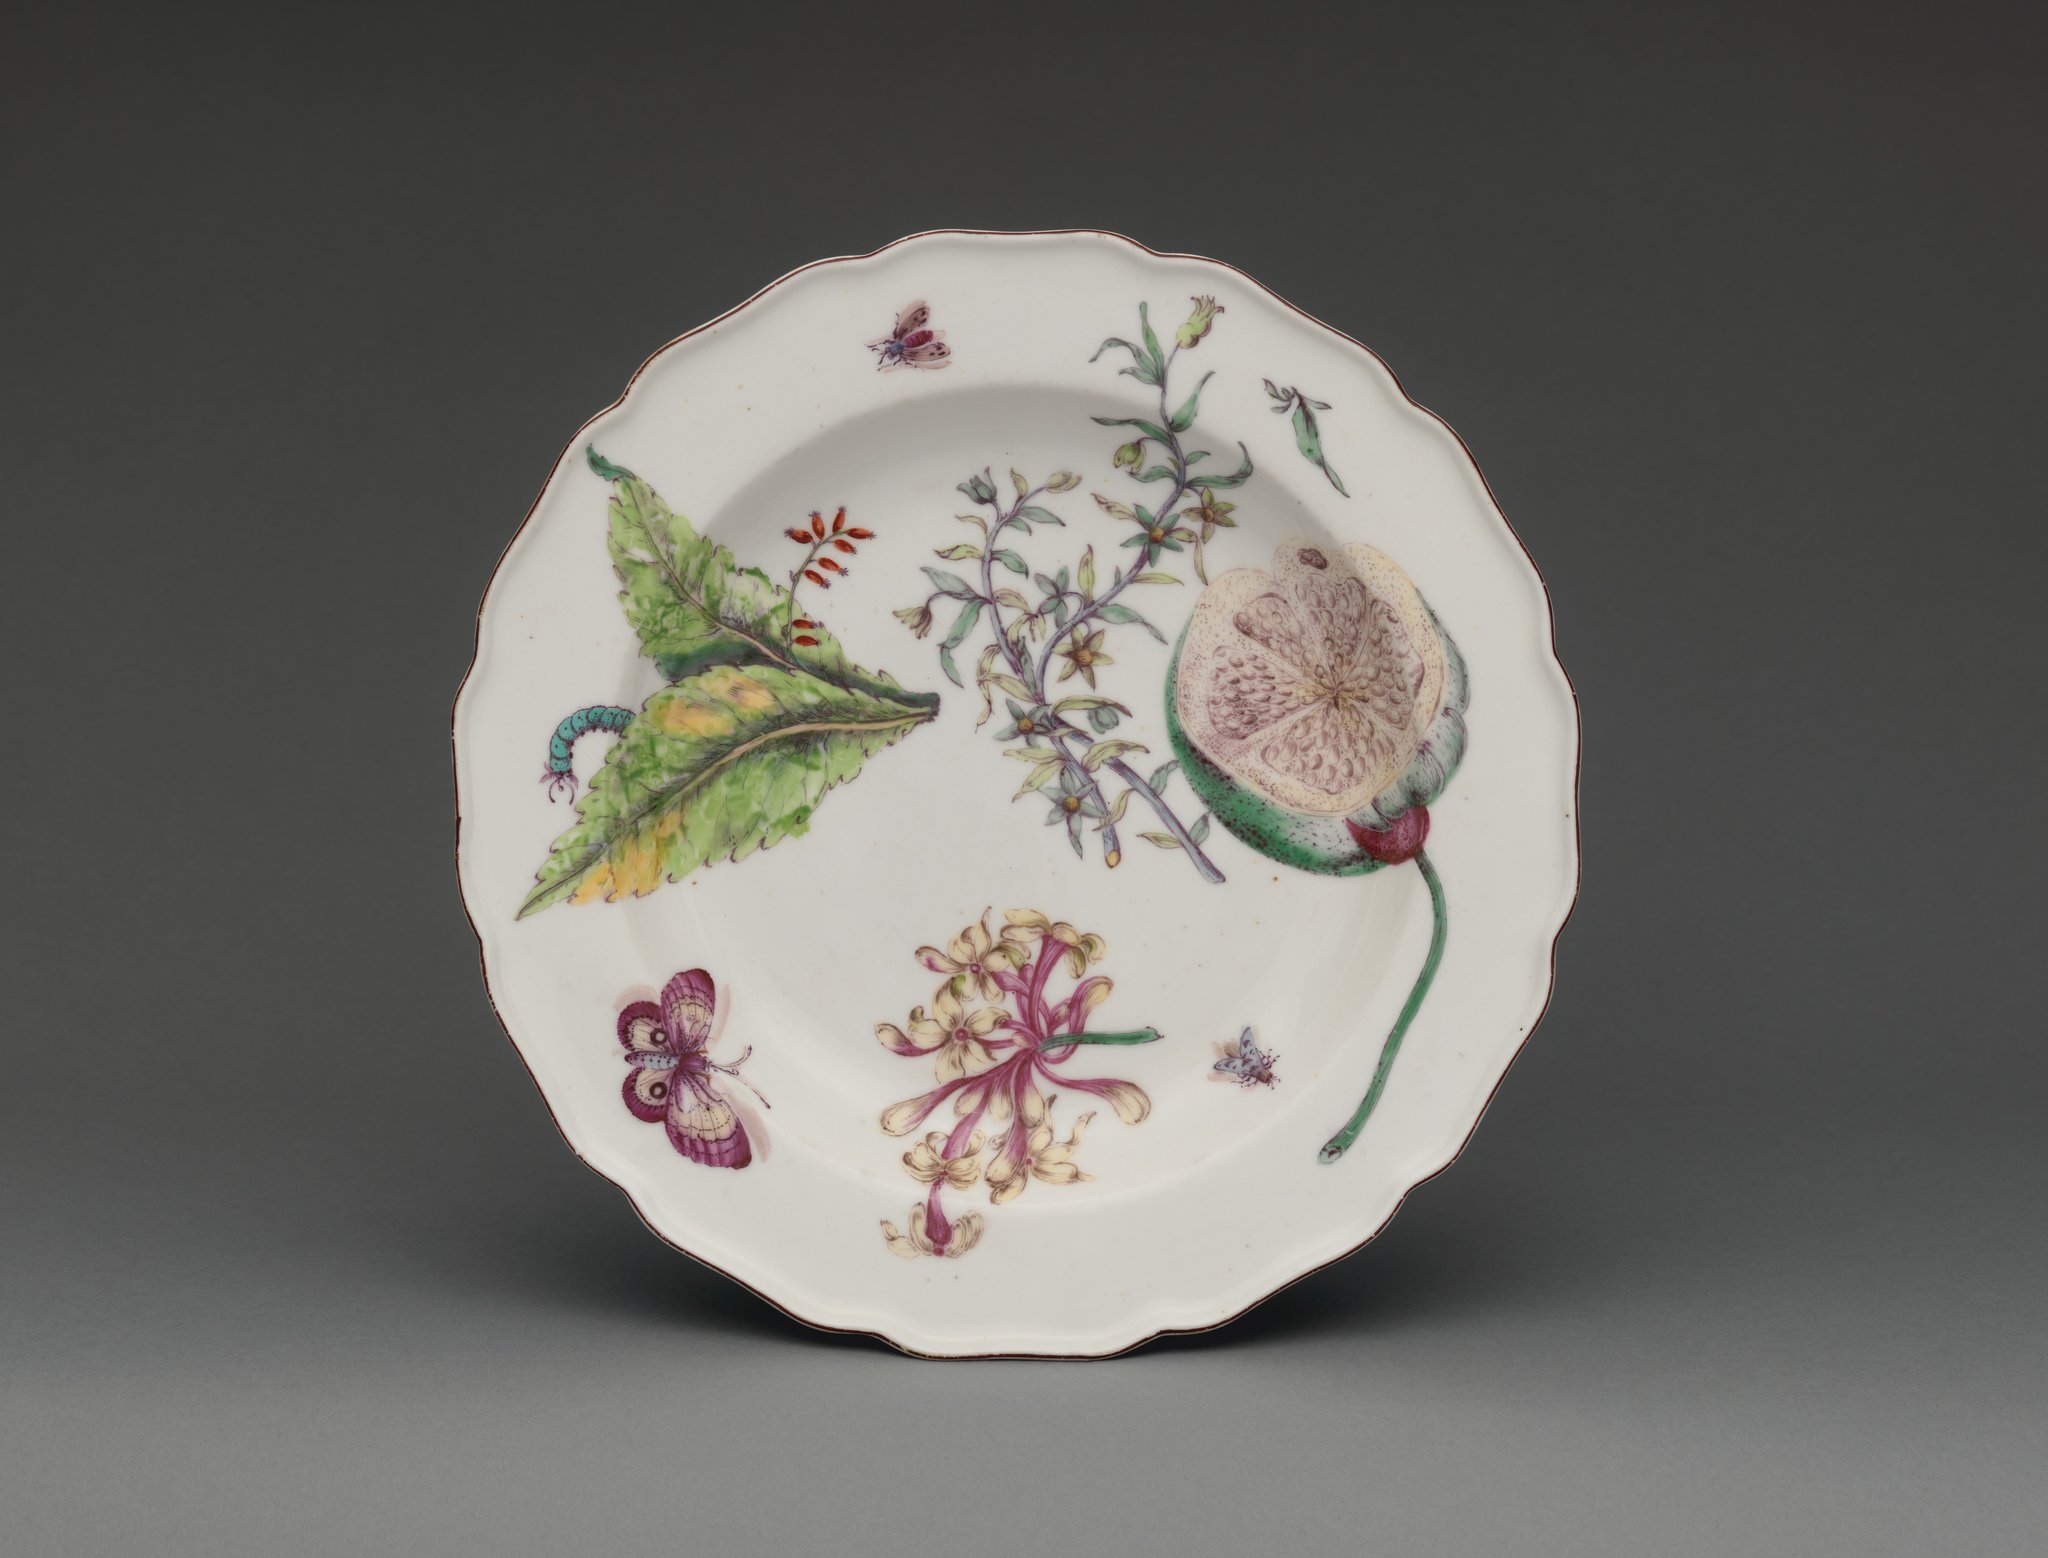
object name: plate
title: Botanical plate with honeysuckle spray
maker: chelsea porcelain manufactory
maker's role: factory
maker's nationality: british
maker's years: 1744-1784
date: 1755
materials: soft paste porcelain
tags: fruit,butterflies